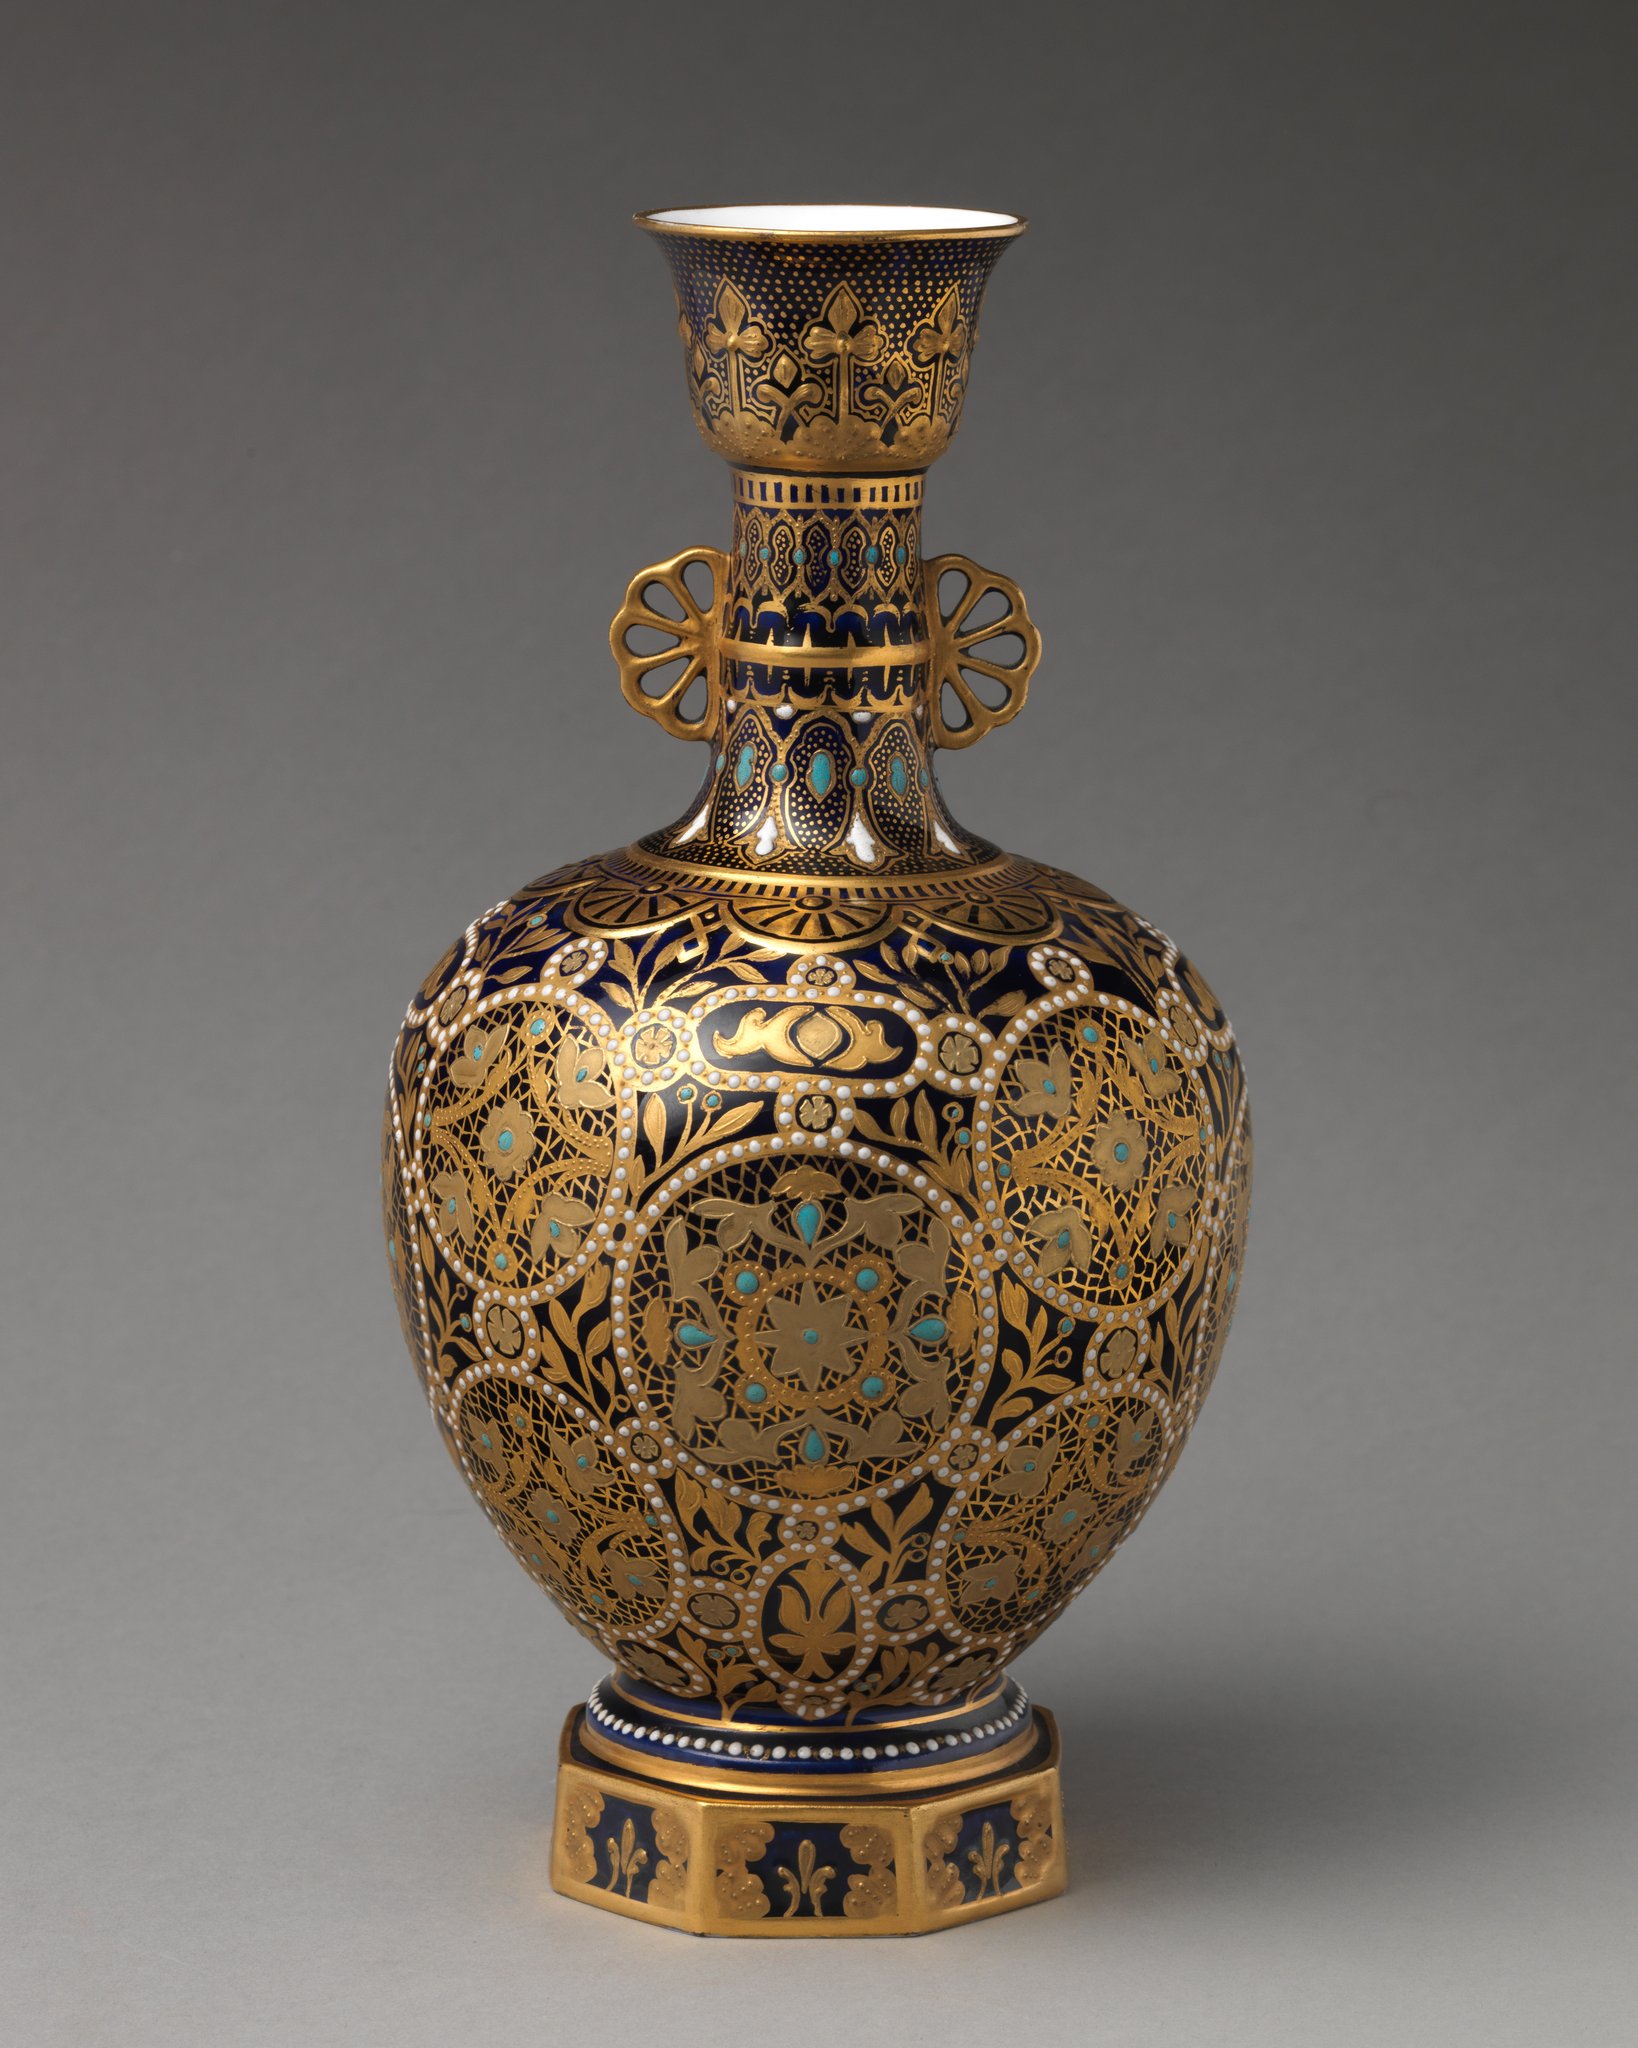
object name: vase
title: Vase with hexagonal foot (one of a pair)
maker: crown derby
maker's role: maker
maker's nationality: british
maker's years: 1750-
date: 1885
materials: bone china, enamel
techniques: gilding